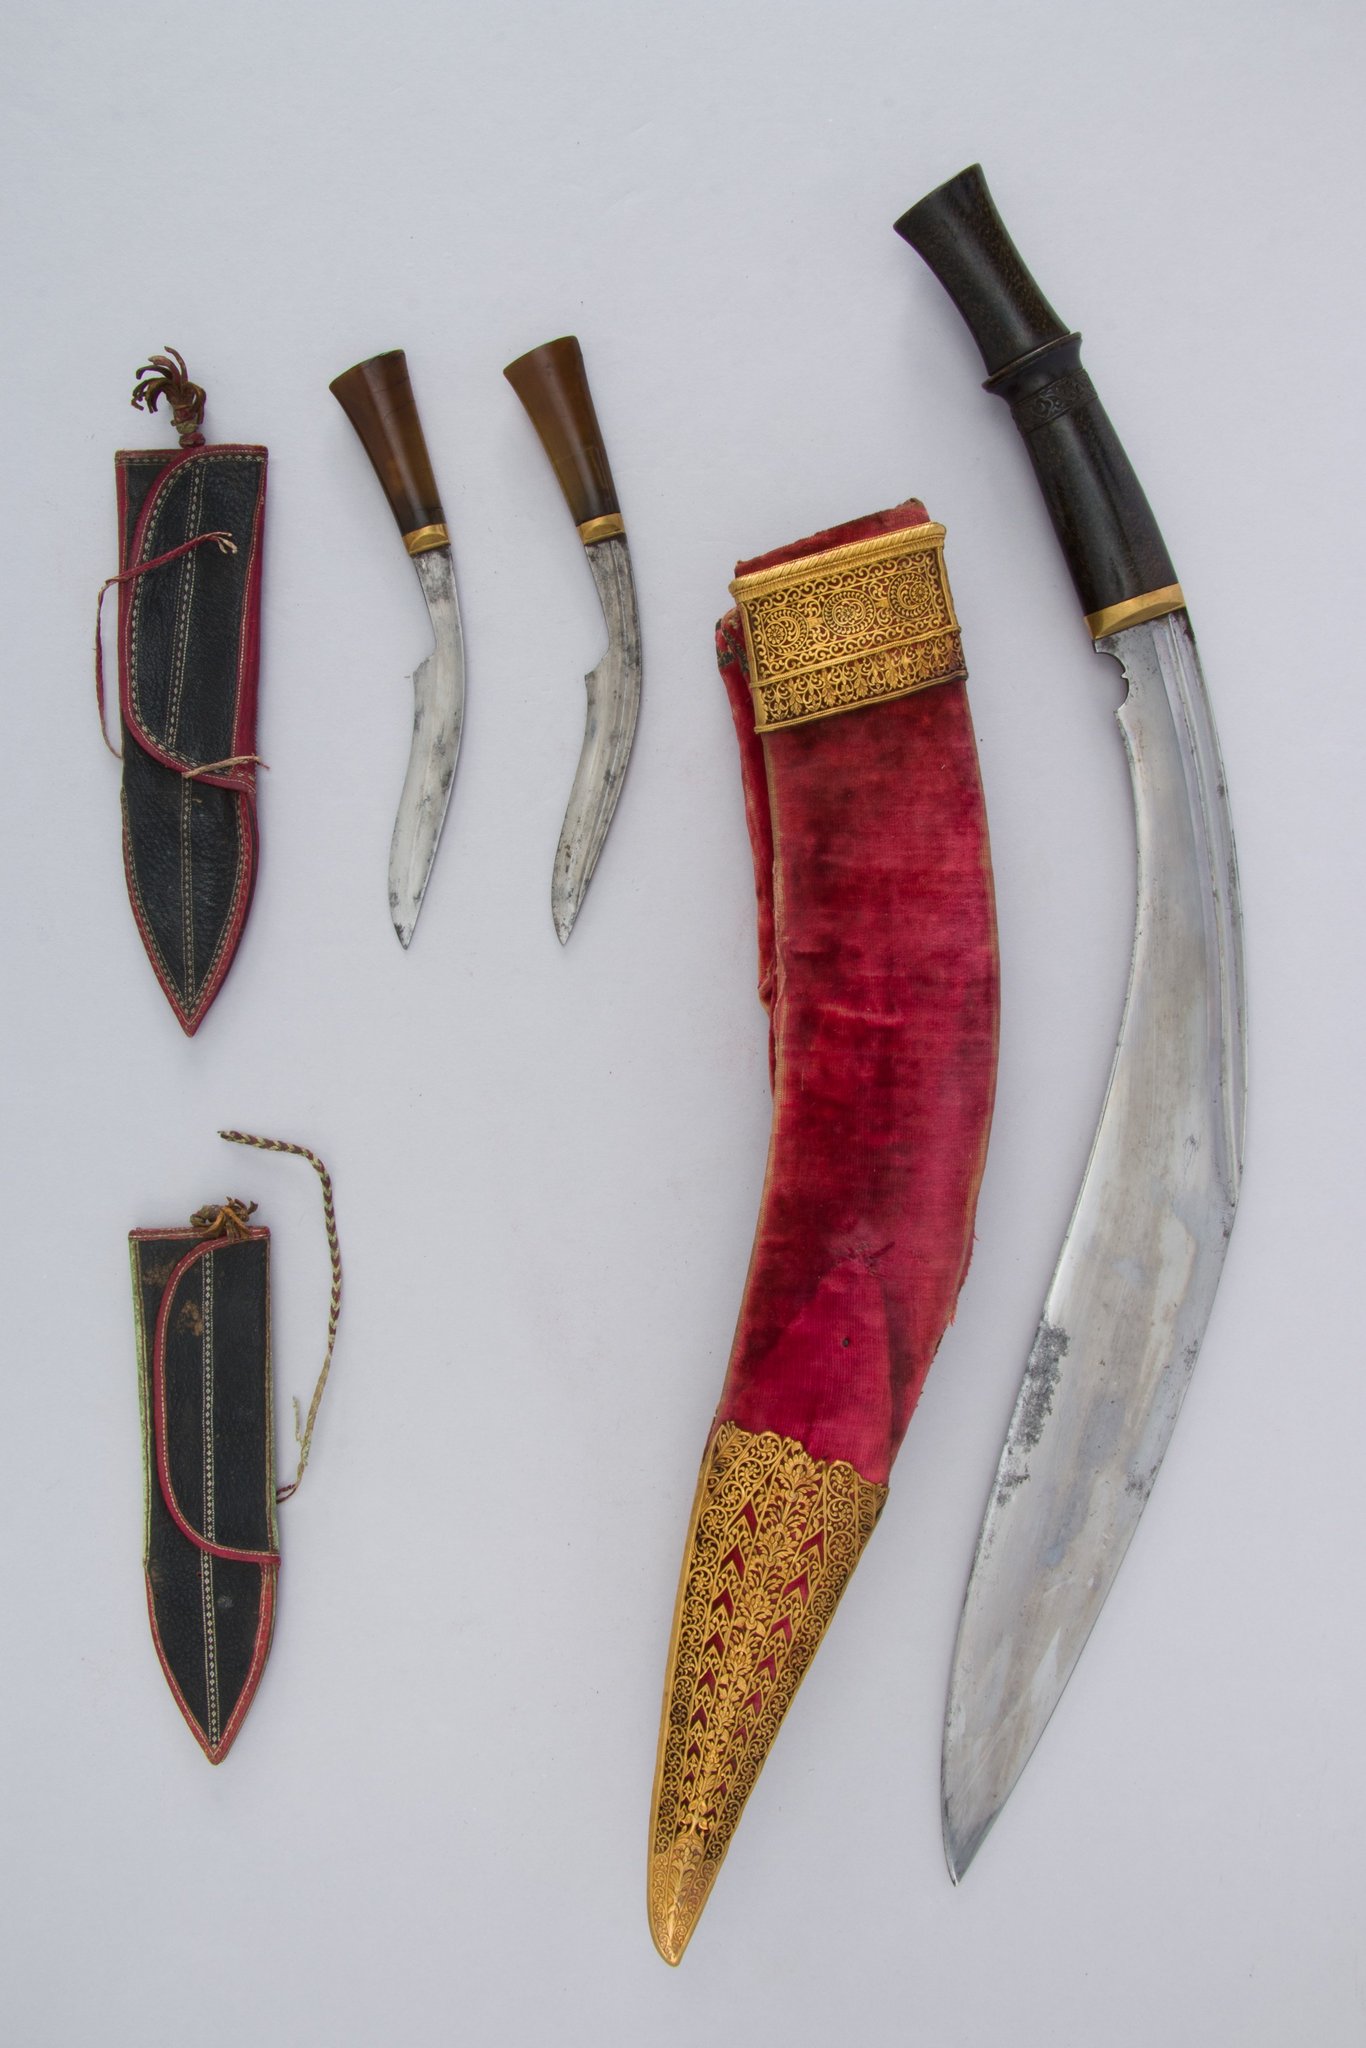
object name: knife kukri with sheath, two small knife and pouch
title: Knife (Kukri) with Two Sheaths, Two Small Knives, and Two Sharpening Pouches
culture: gurkha or indian or nepalese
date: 1701-1900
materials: gold, horn, leather, steel, velvet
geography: india